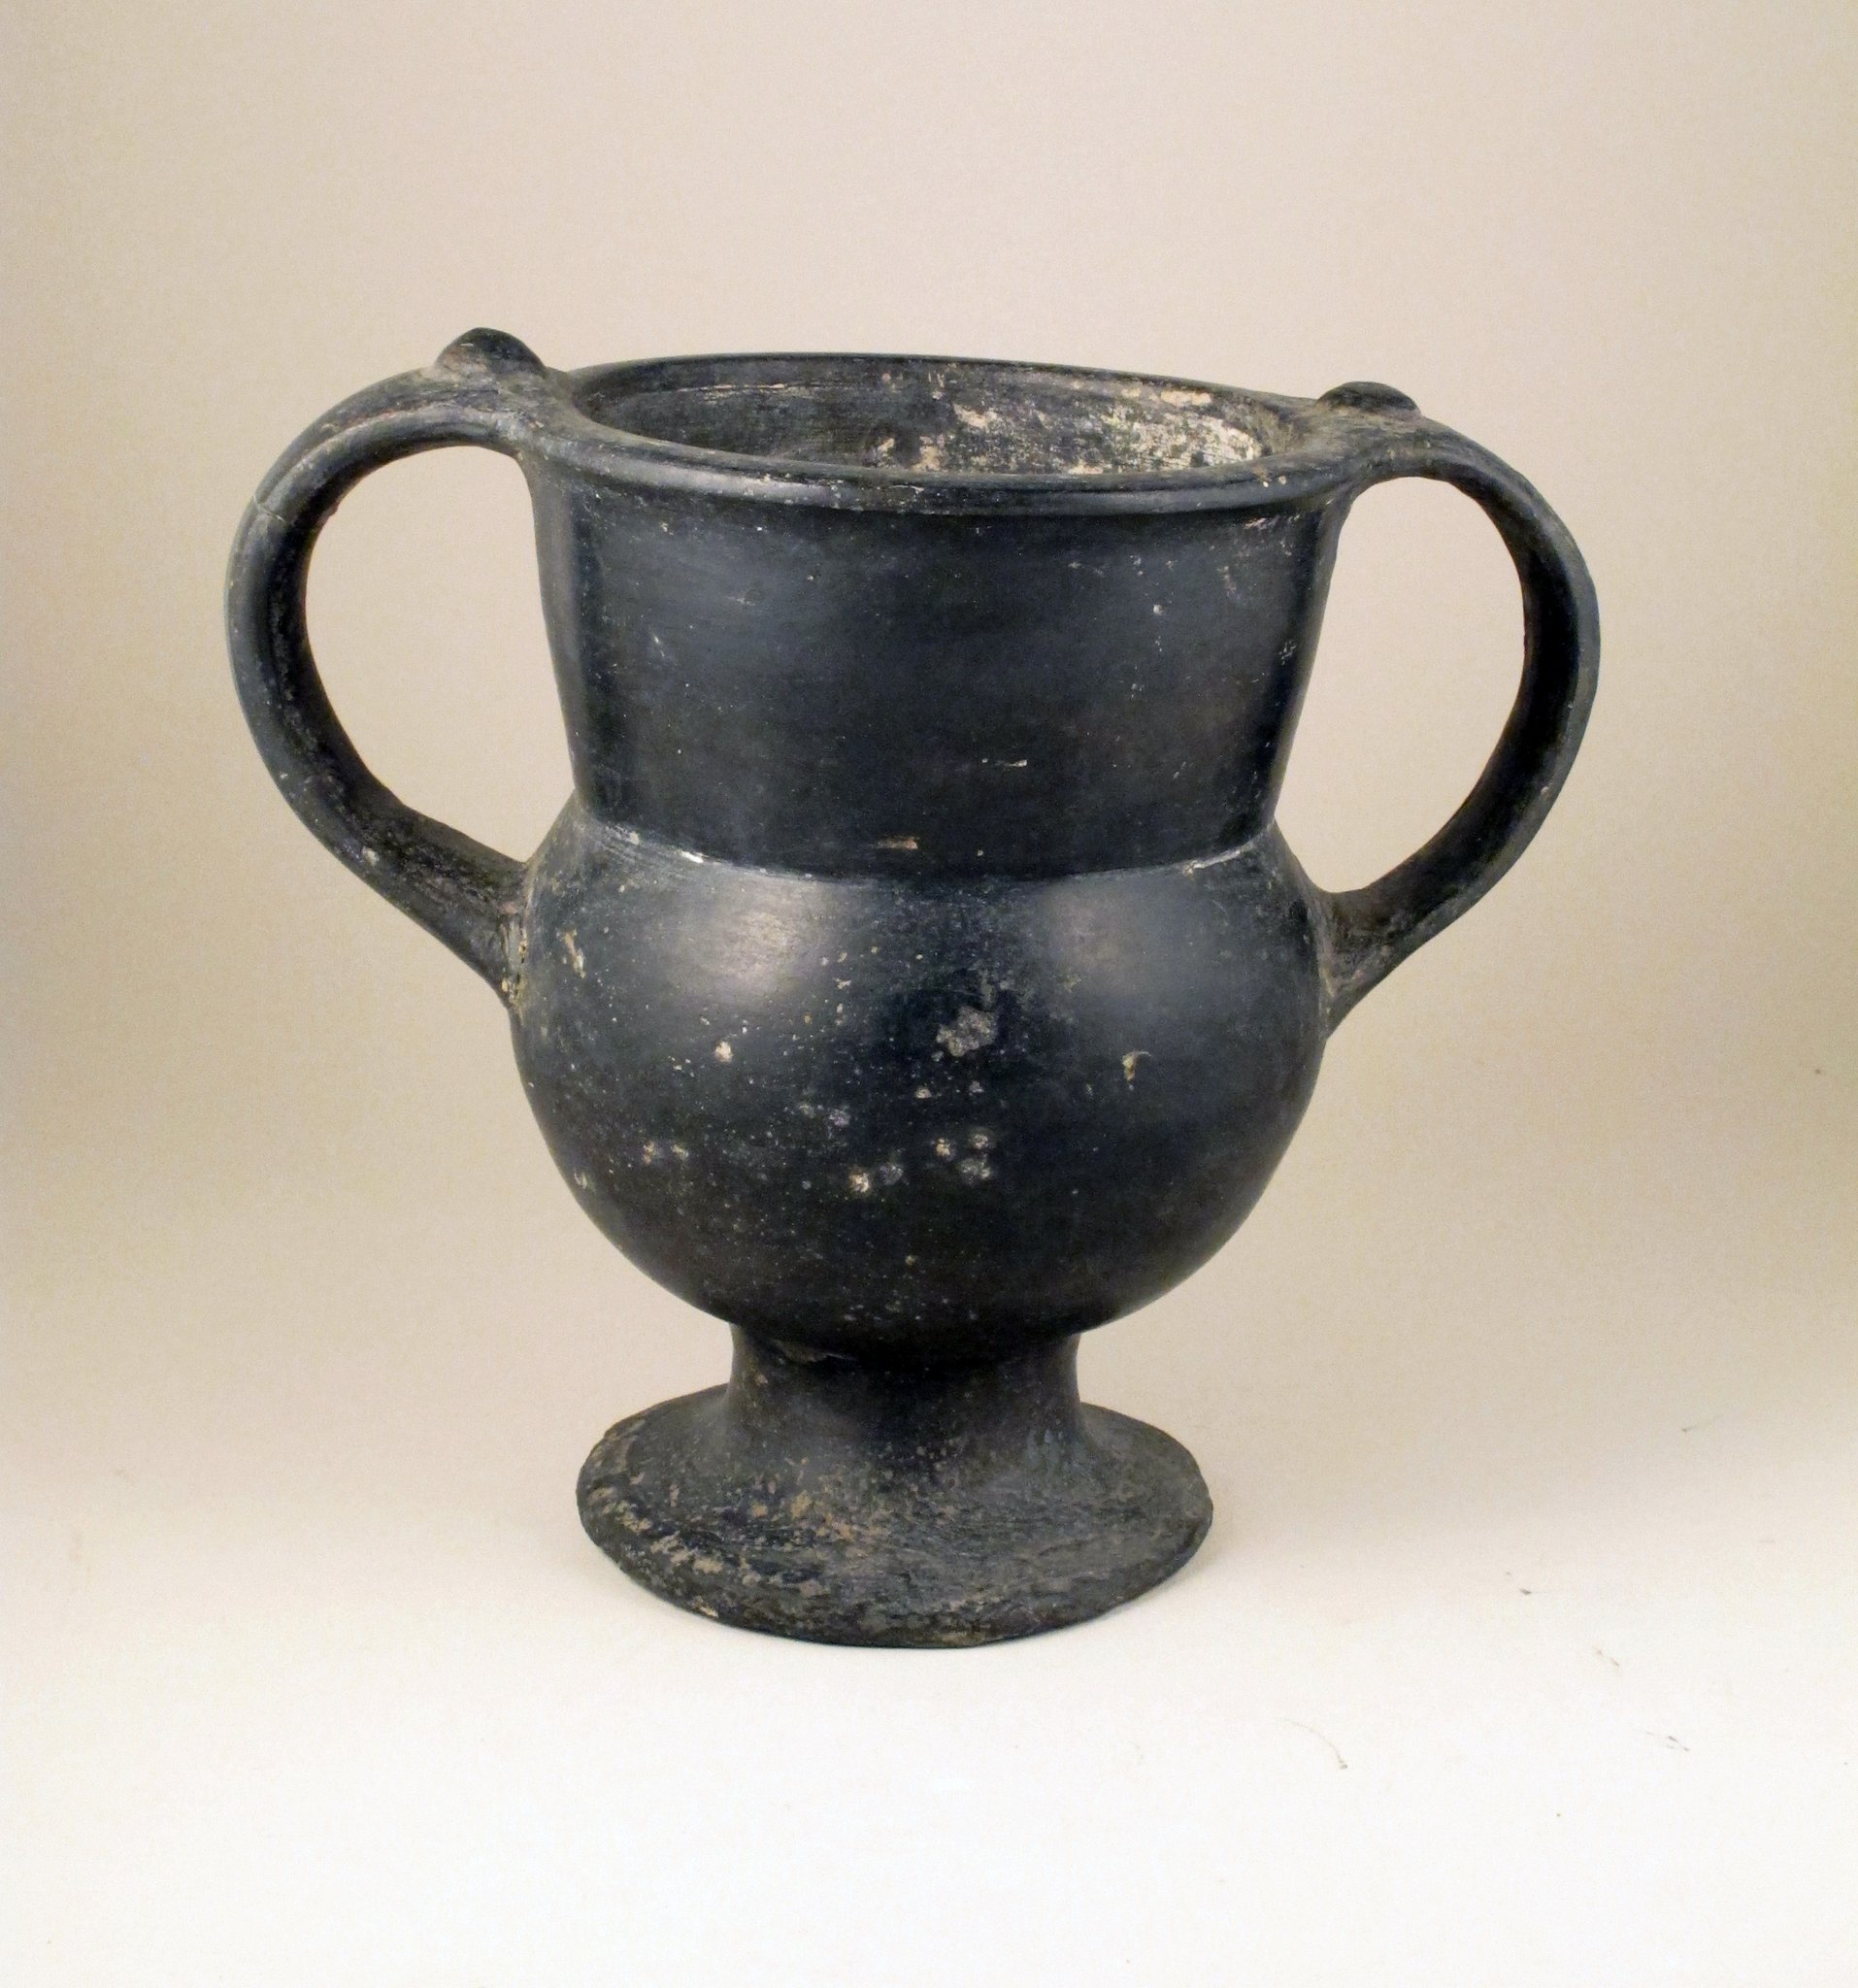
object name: kantharos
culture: etruscan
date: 550-501 BCE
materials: terracotta